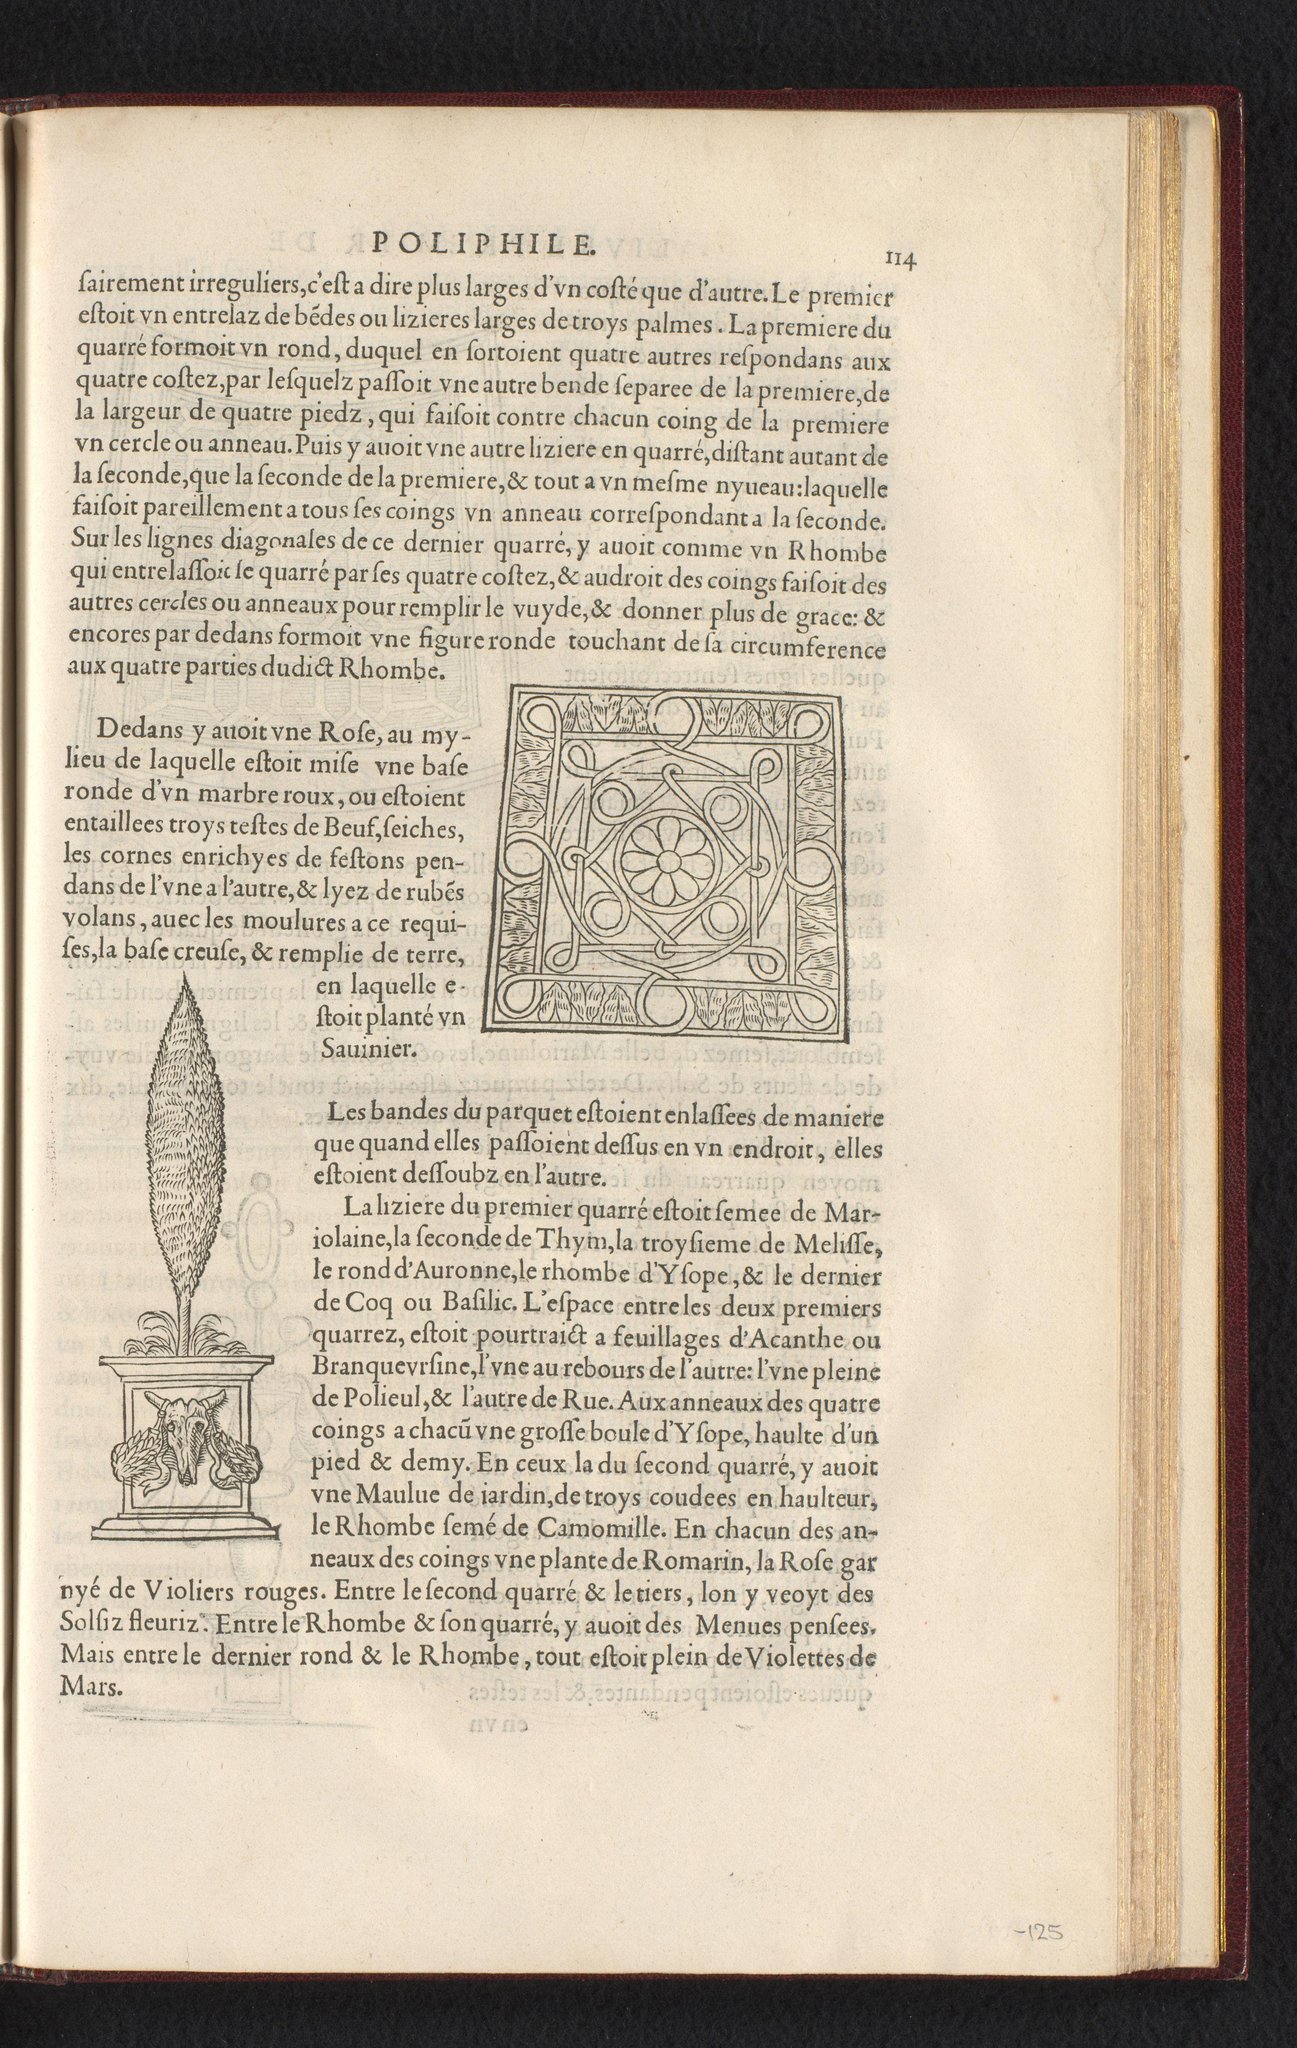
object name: page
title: Detail van tuinontwerp en een boom in een grote vaas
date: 1546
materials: paper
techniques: letterpress printing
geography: paris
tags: trees, plan, map of garden, (scenes from) specific works of literature: colonna, hypnerotomachia poliphili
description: Prent uit: Colonna, Francesco. Hypnerotomachie ou discours du songe de Poliphile, deduisant comme amour le combat a l'occasion de Polia. Parijs: Jacques Kerver, 1546, recto fol. 114.